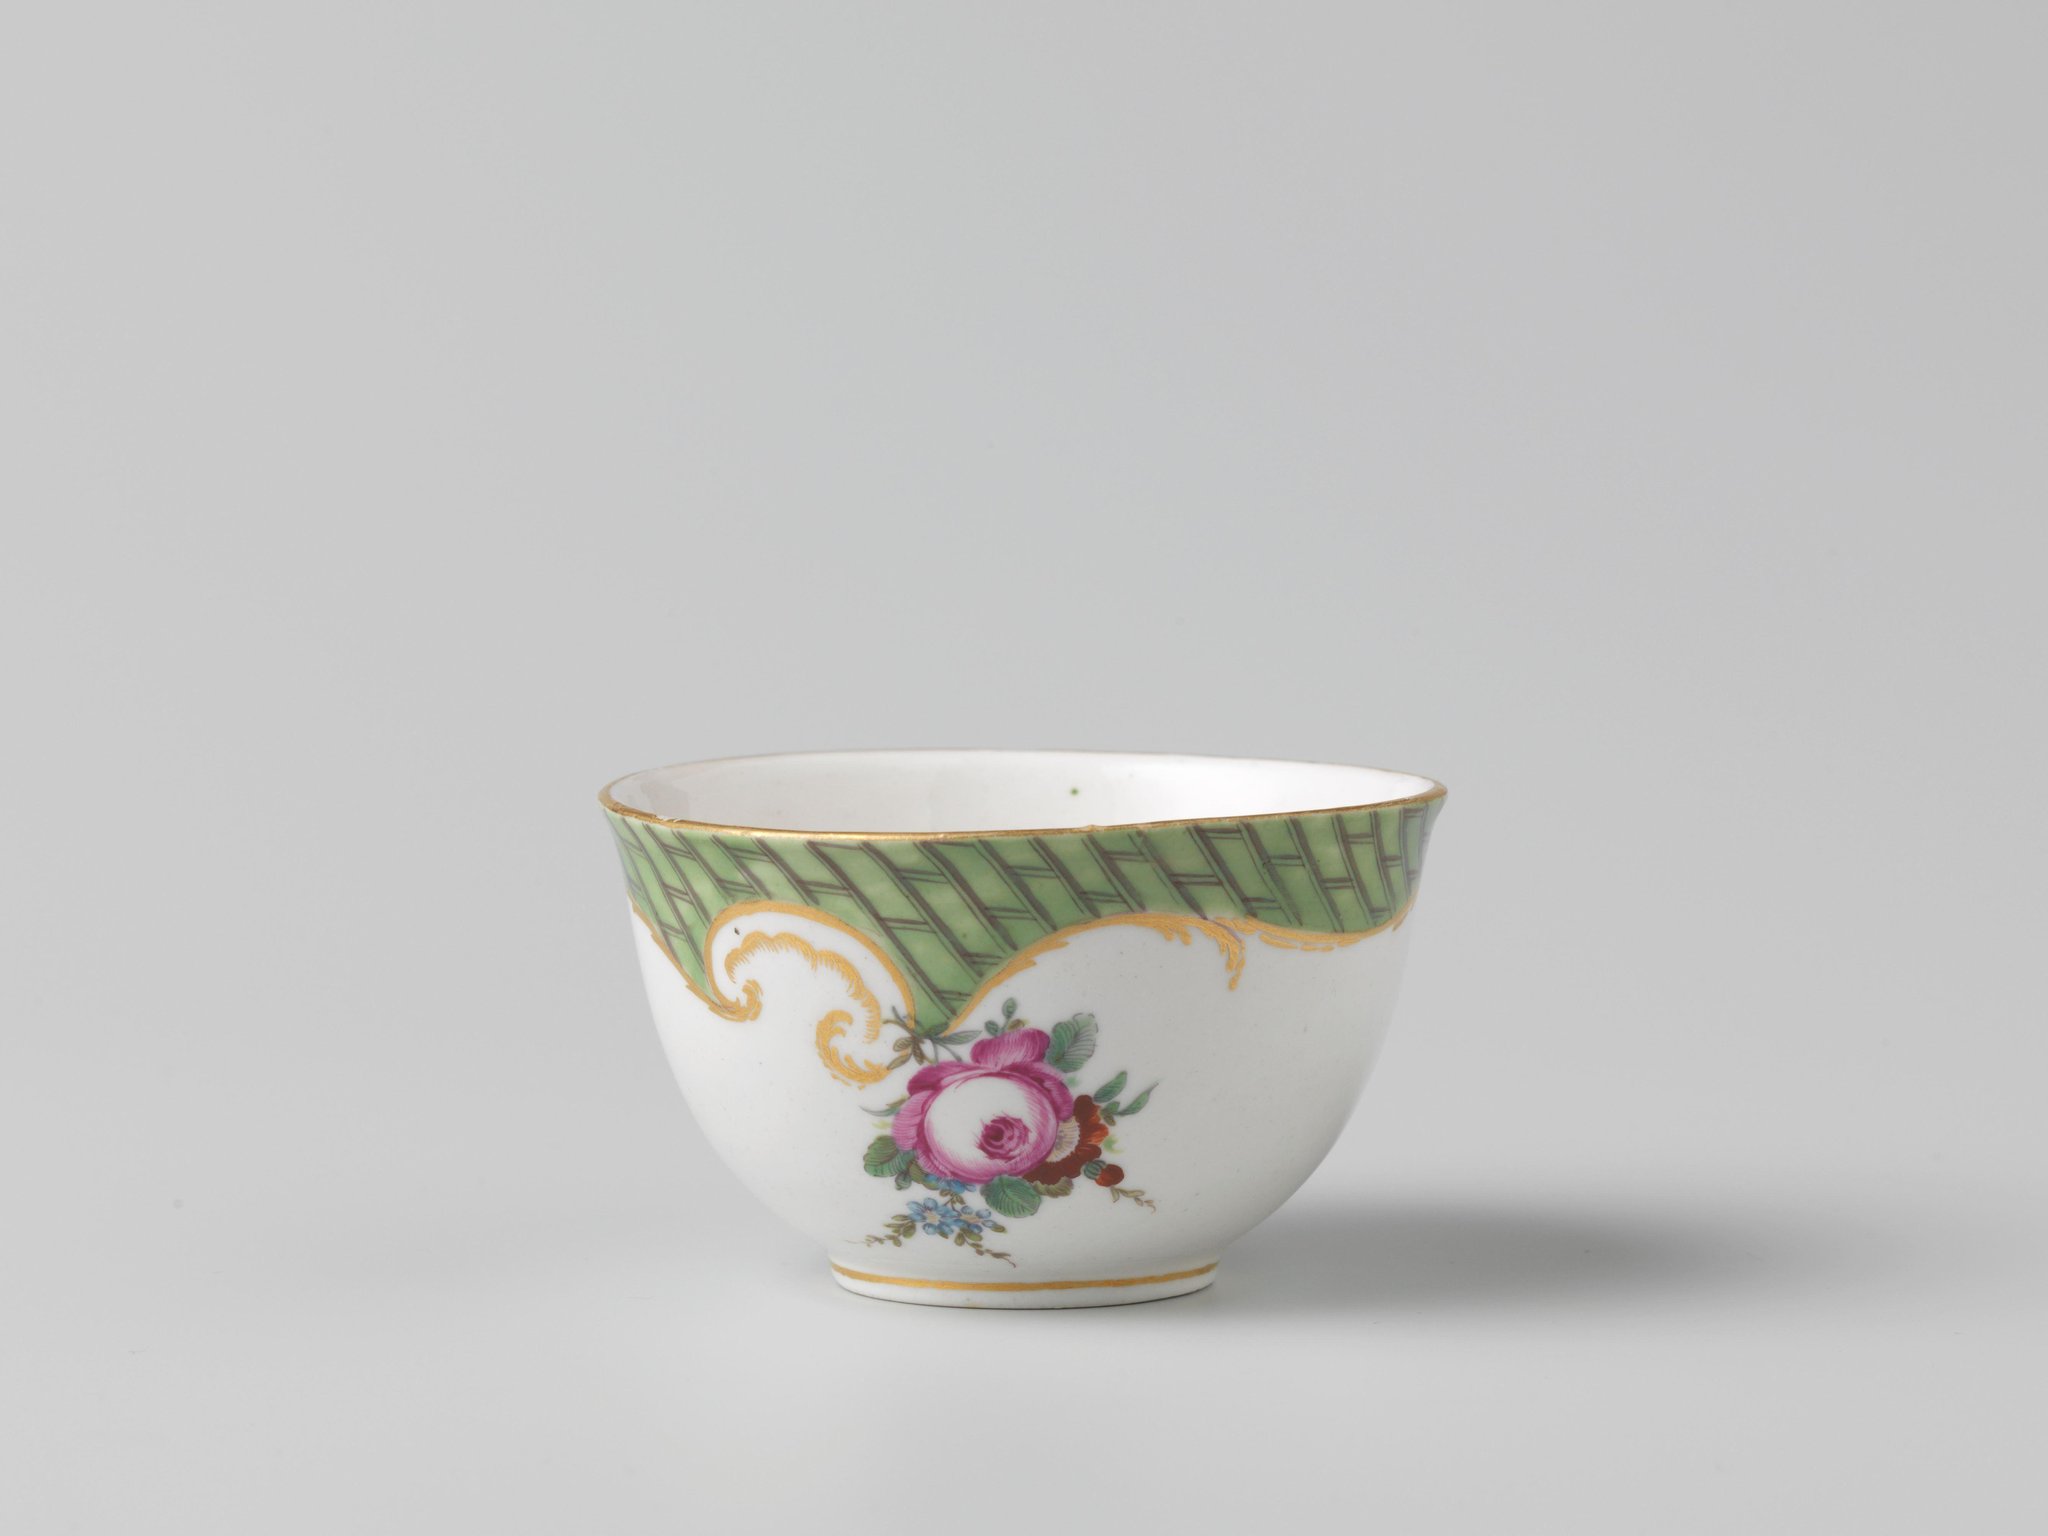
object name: kop en schotel, kop en schotel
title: Kop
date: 1774-1784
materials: porcelain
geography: loosdrecht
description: Kop zonder oor van porselein. Veelkleurig beschilderd met bloemboeketten en een laddermotief langs de randen.